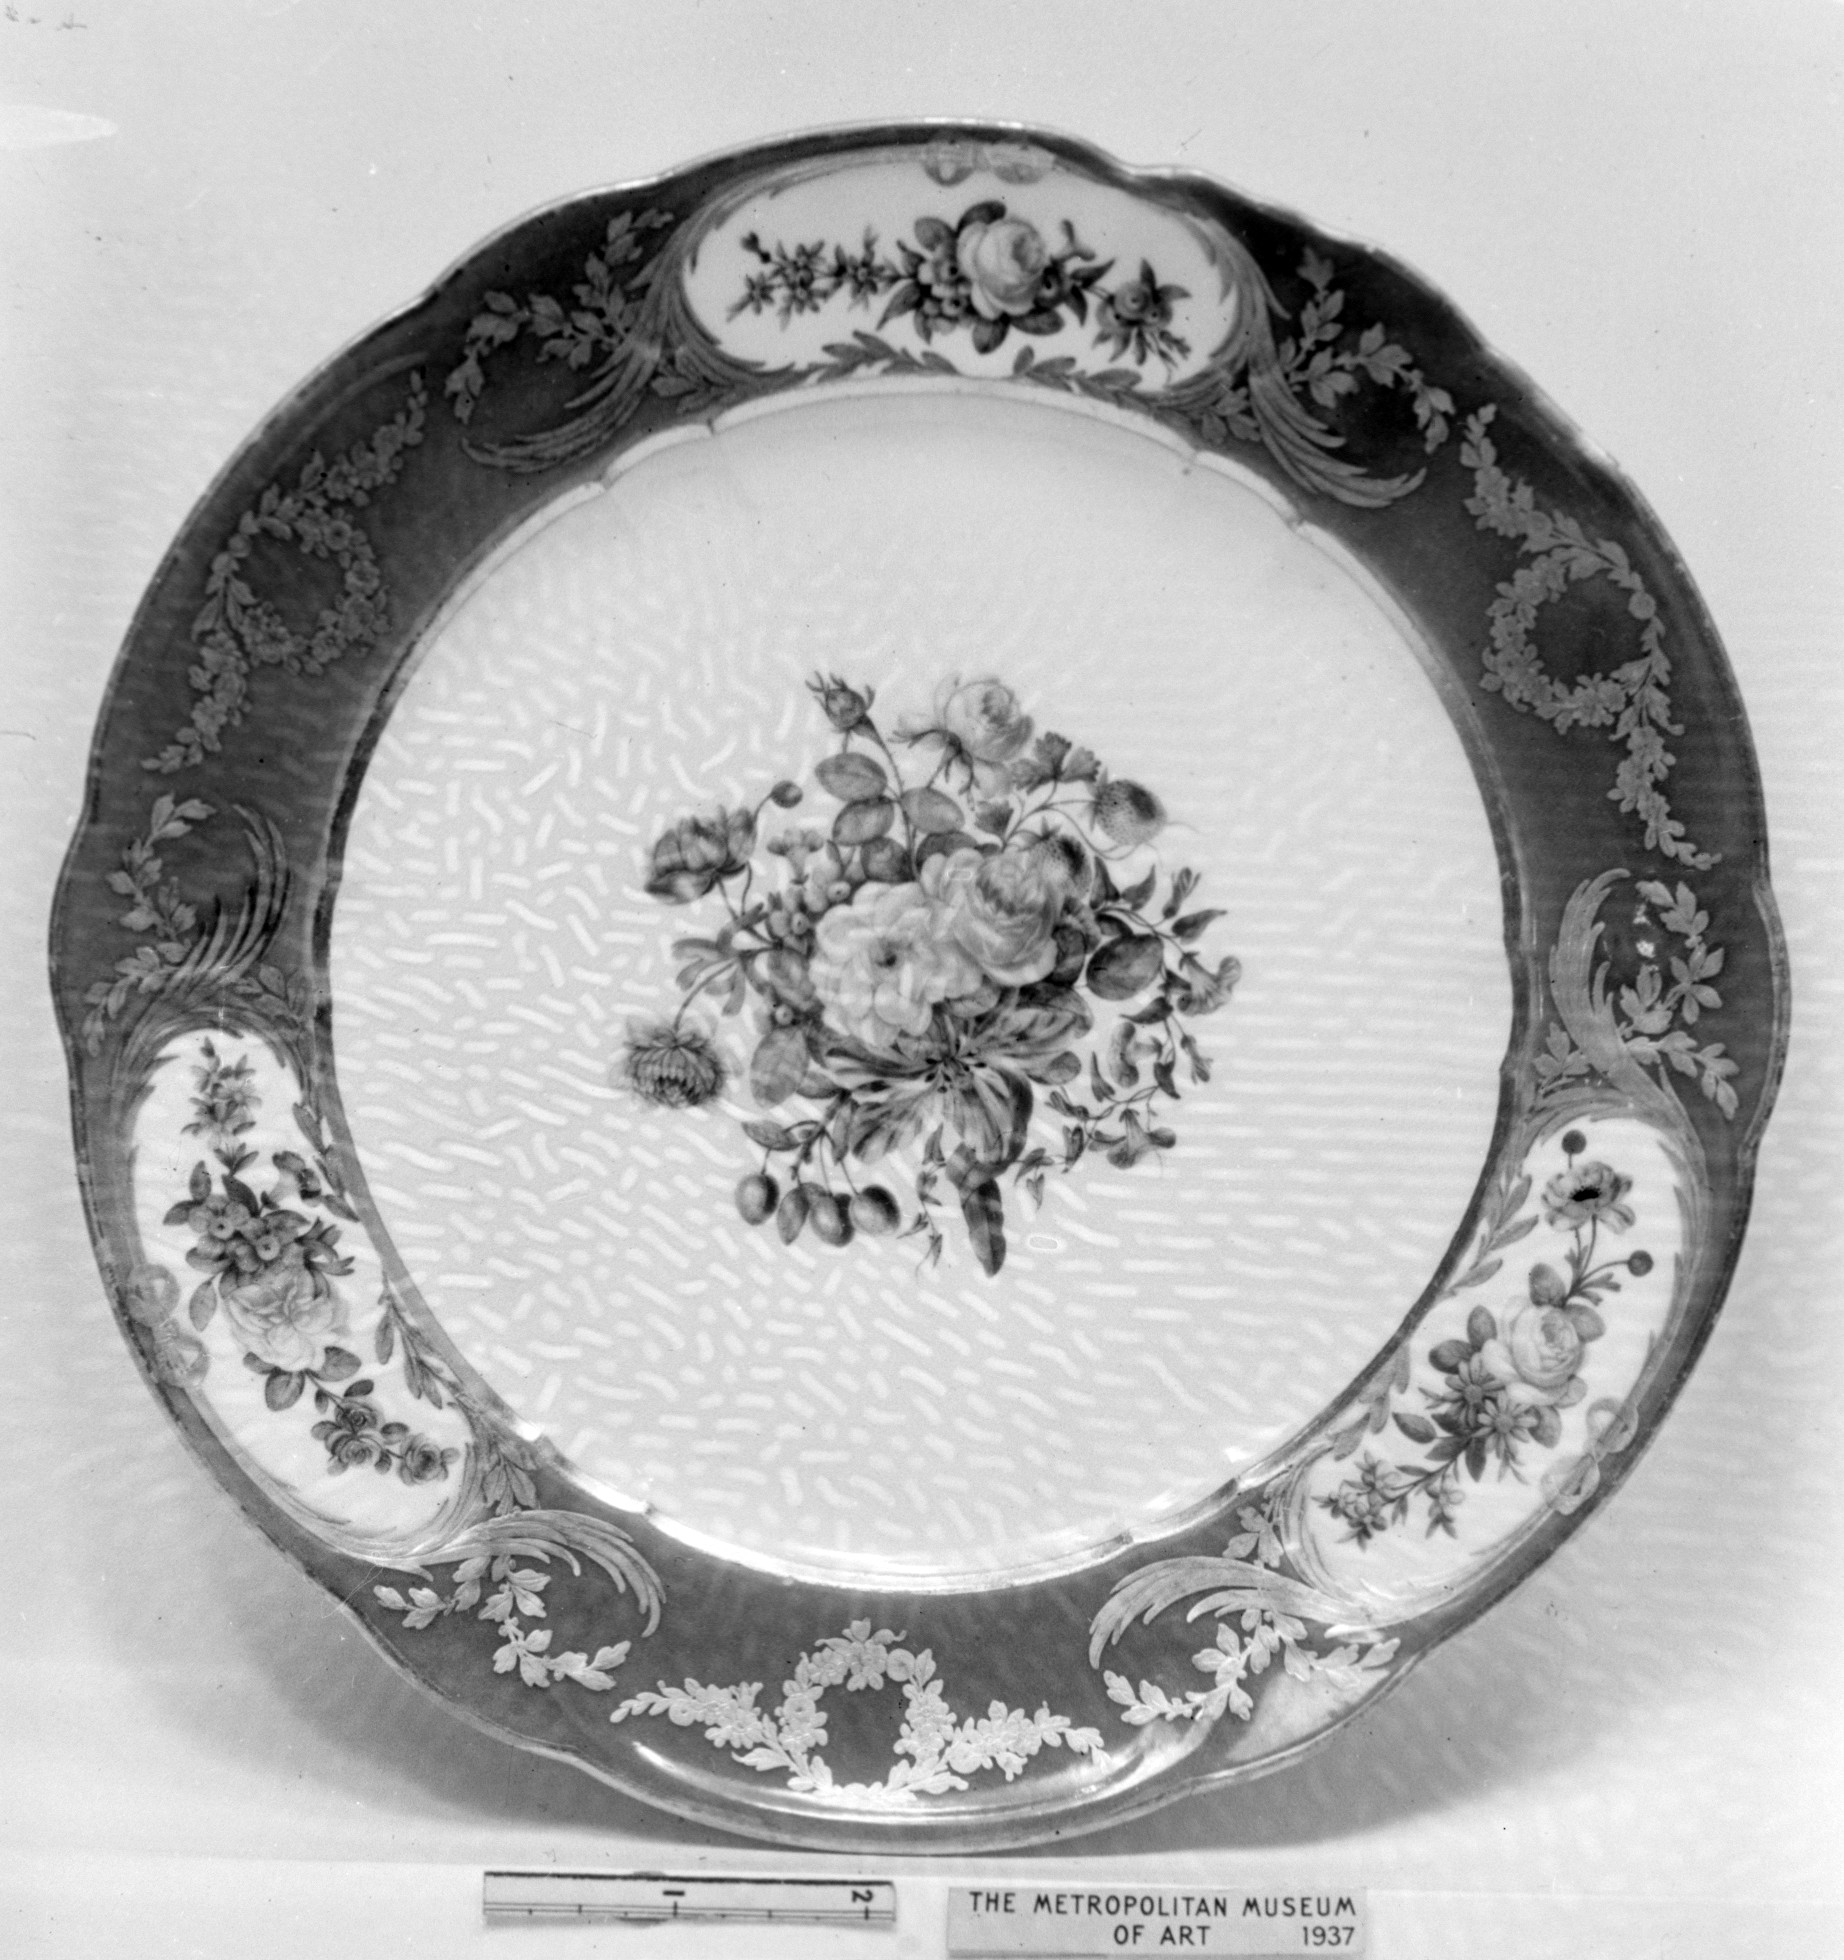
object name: plate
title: Plate (part of a service)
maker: sèvres manufactory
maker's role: manufactory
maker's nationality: french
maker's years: 1740-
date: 1775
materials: soft paste porcelain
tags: fruit,flowers